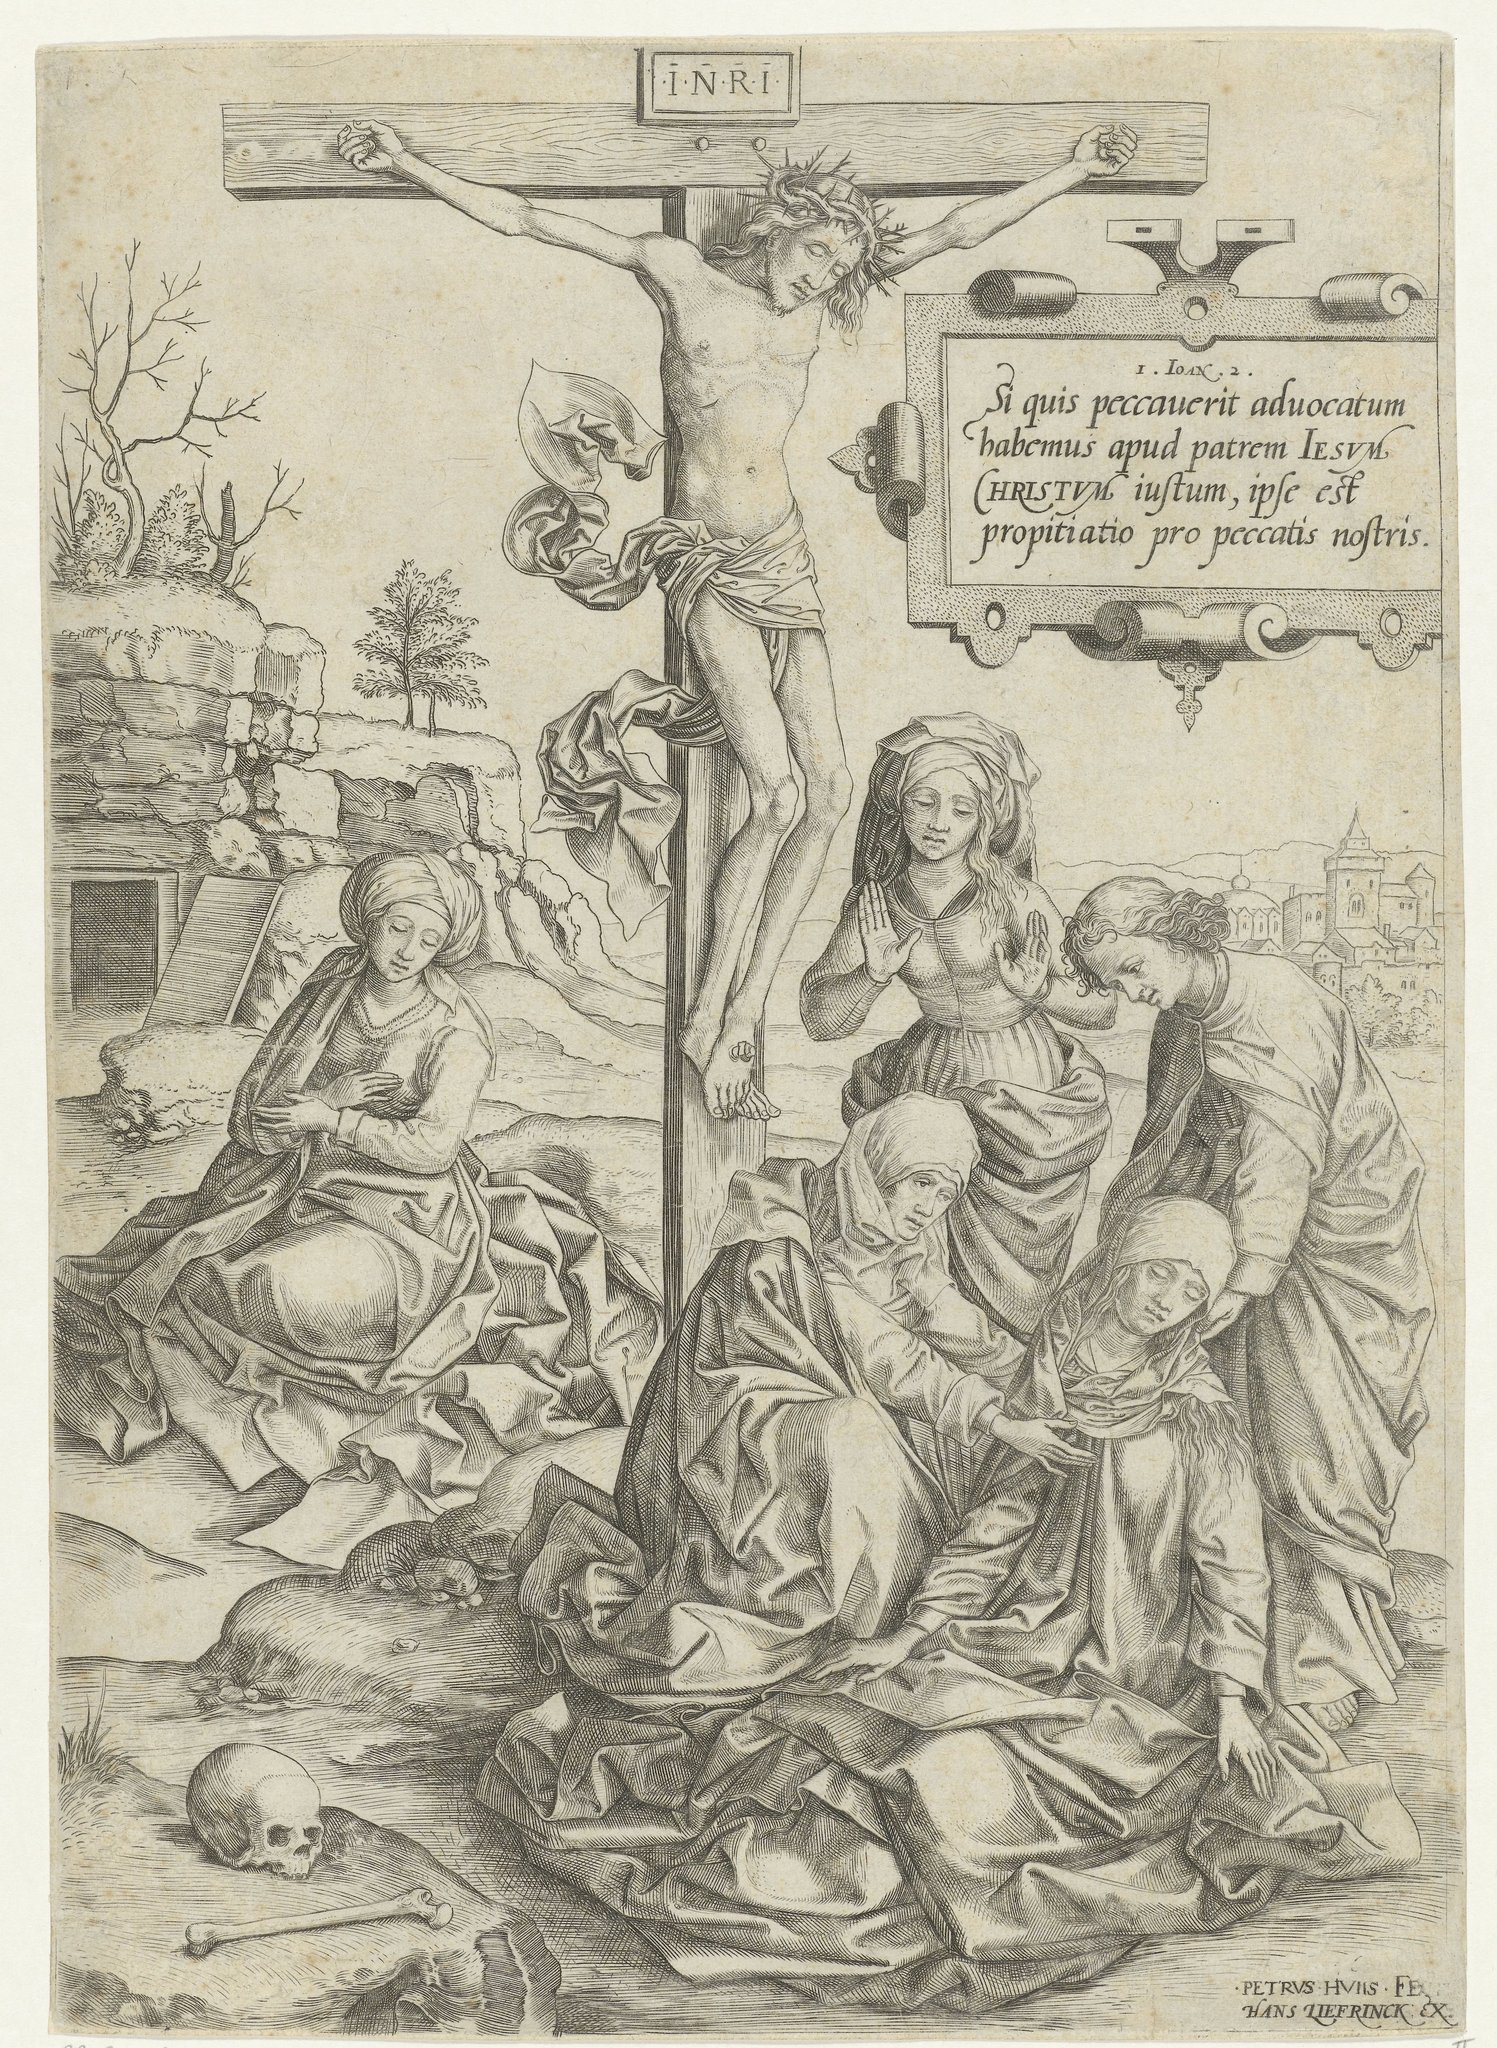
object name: print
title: Christus aan het kruis met bezwijmende Maria en andere heiligen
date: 1545-1577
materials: paper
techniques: engraving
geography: antwerp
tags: crucified christ with mary, john, and mary magdalene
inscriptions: signature: ‘PETRUS HUIIS FE.’, address: ‘HANS LIEFRINCK EX.’, collector's mark: Lugt 2228, inscription: ‘Si quis peccaverit advocatum... nostris’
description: Christus aan het kruis. Aan de voet van het kruis wordt de bezwijmde Maria ondersteund door Johannes en een vrouw. Staande en knielende vrouw erachter. Linksvoor een doodshoofd. Linksachter het graf. Rechts een cartouche met een verwijzing naar 1 Joh. 2 en een bijbeltekst in het Latijn.